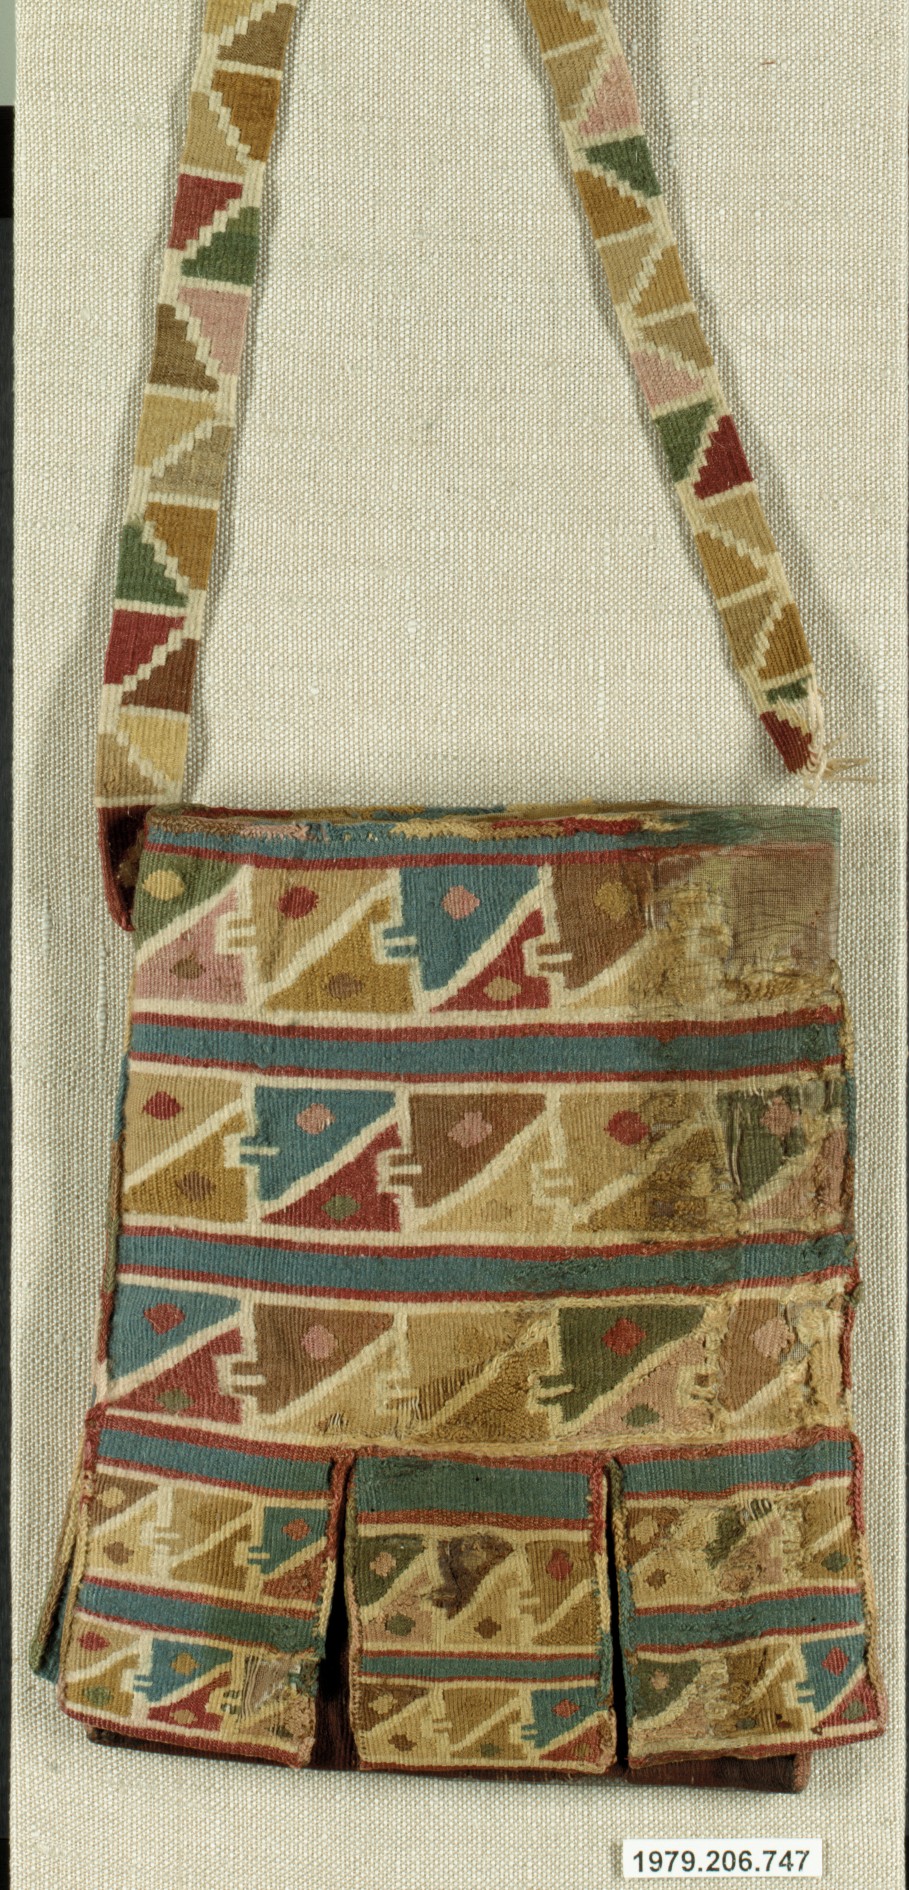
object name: bag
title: Tapestry Bag with Pockets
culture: wari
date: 601-900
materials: animal fiber, cotton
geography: peru